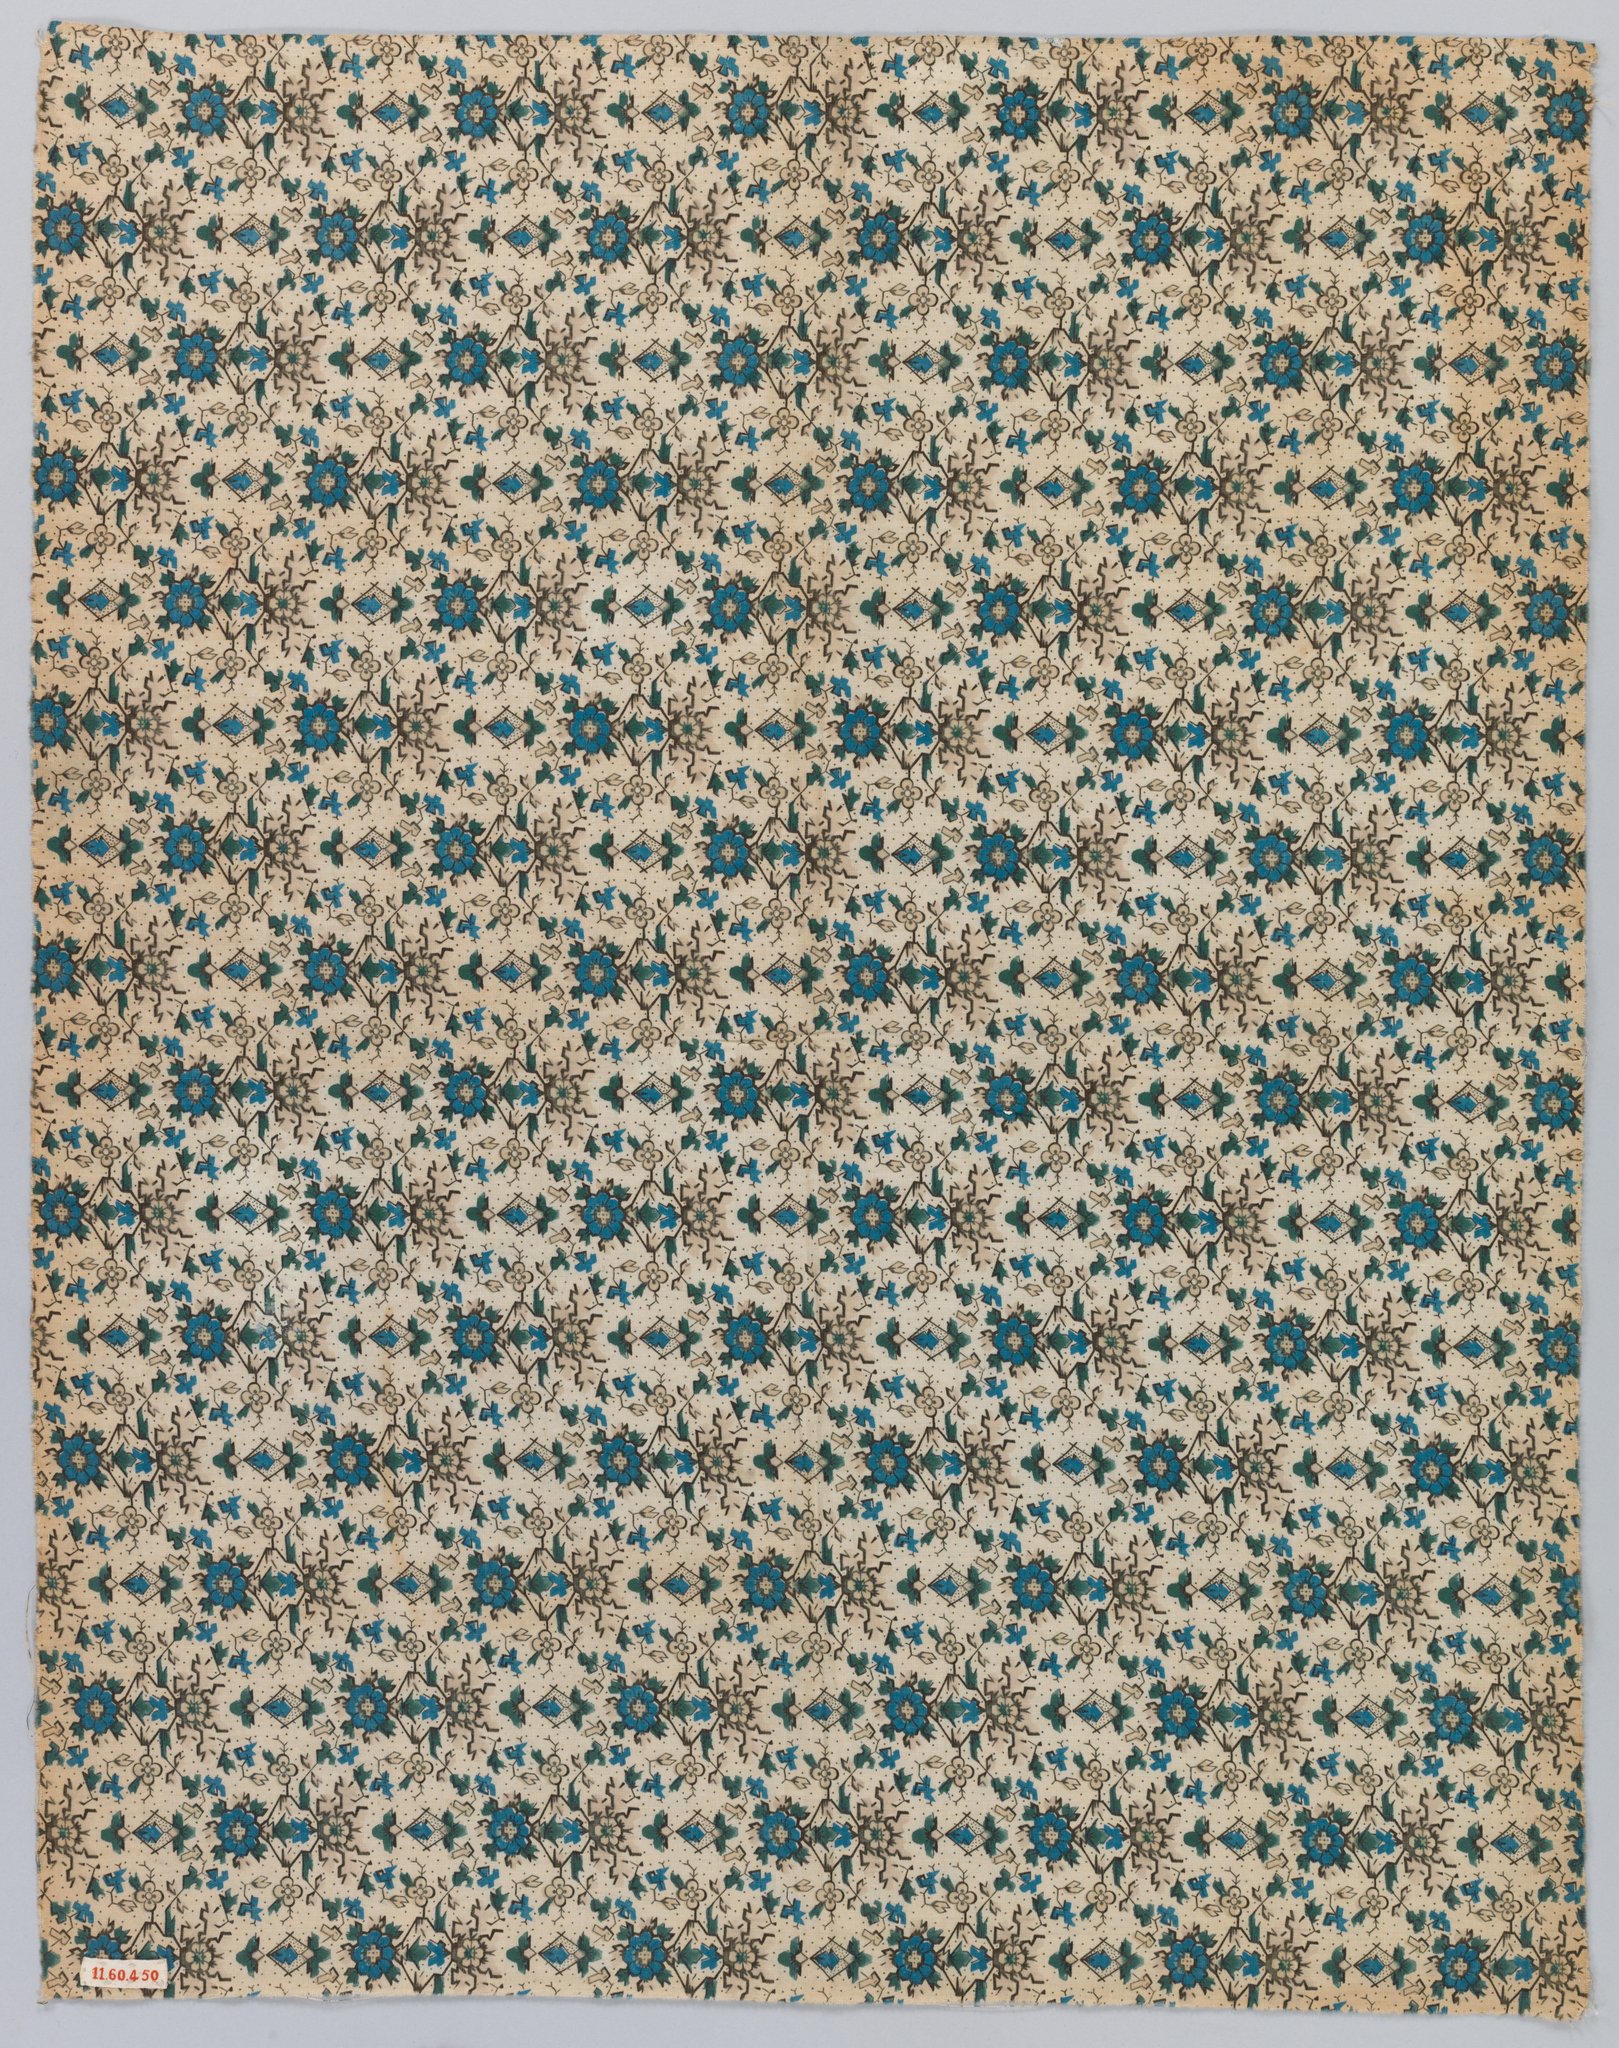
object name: piece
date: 1850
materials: cotton